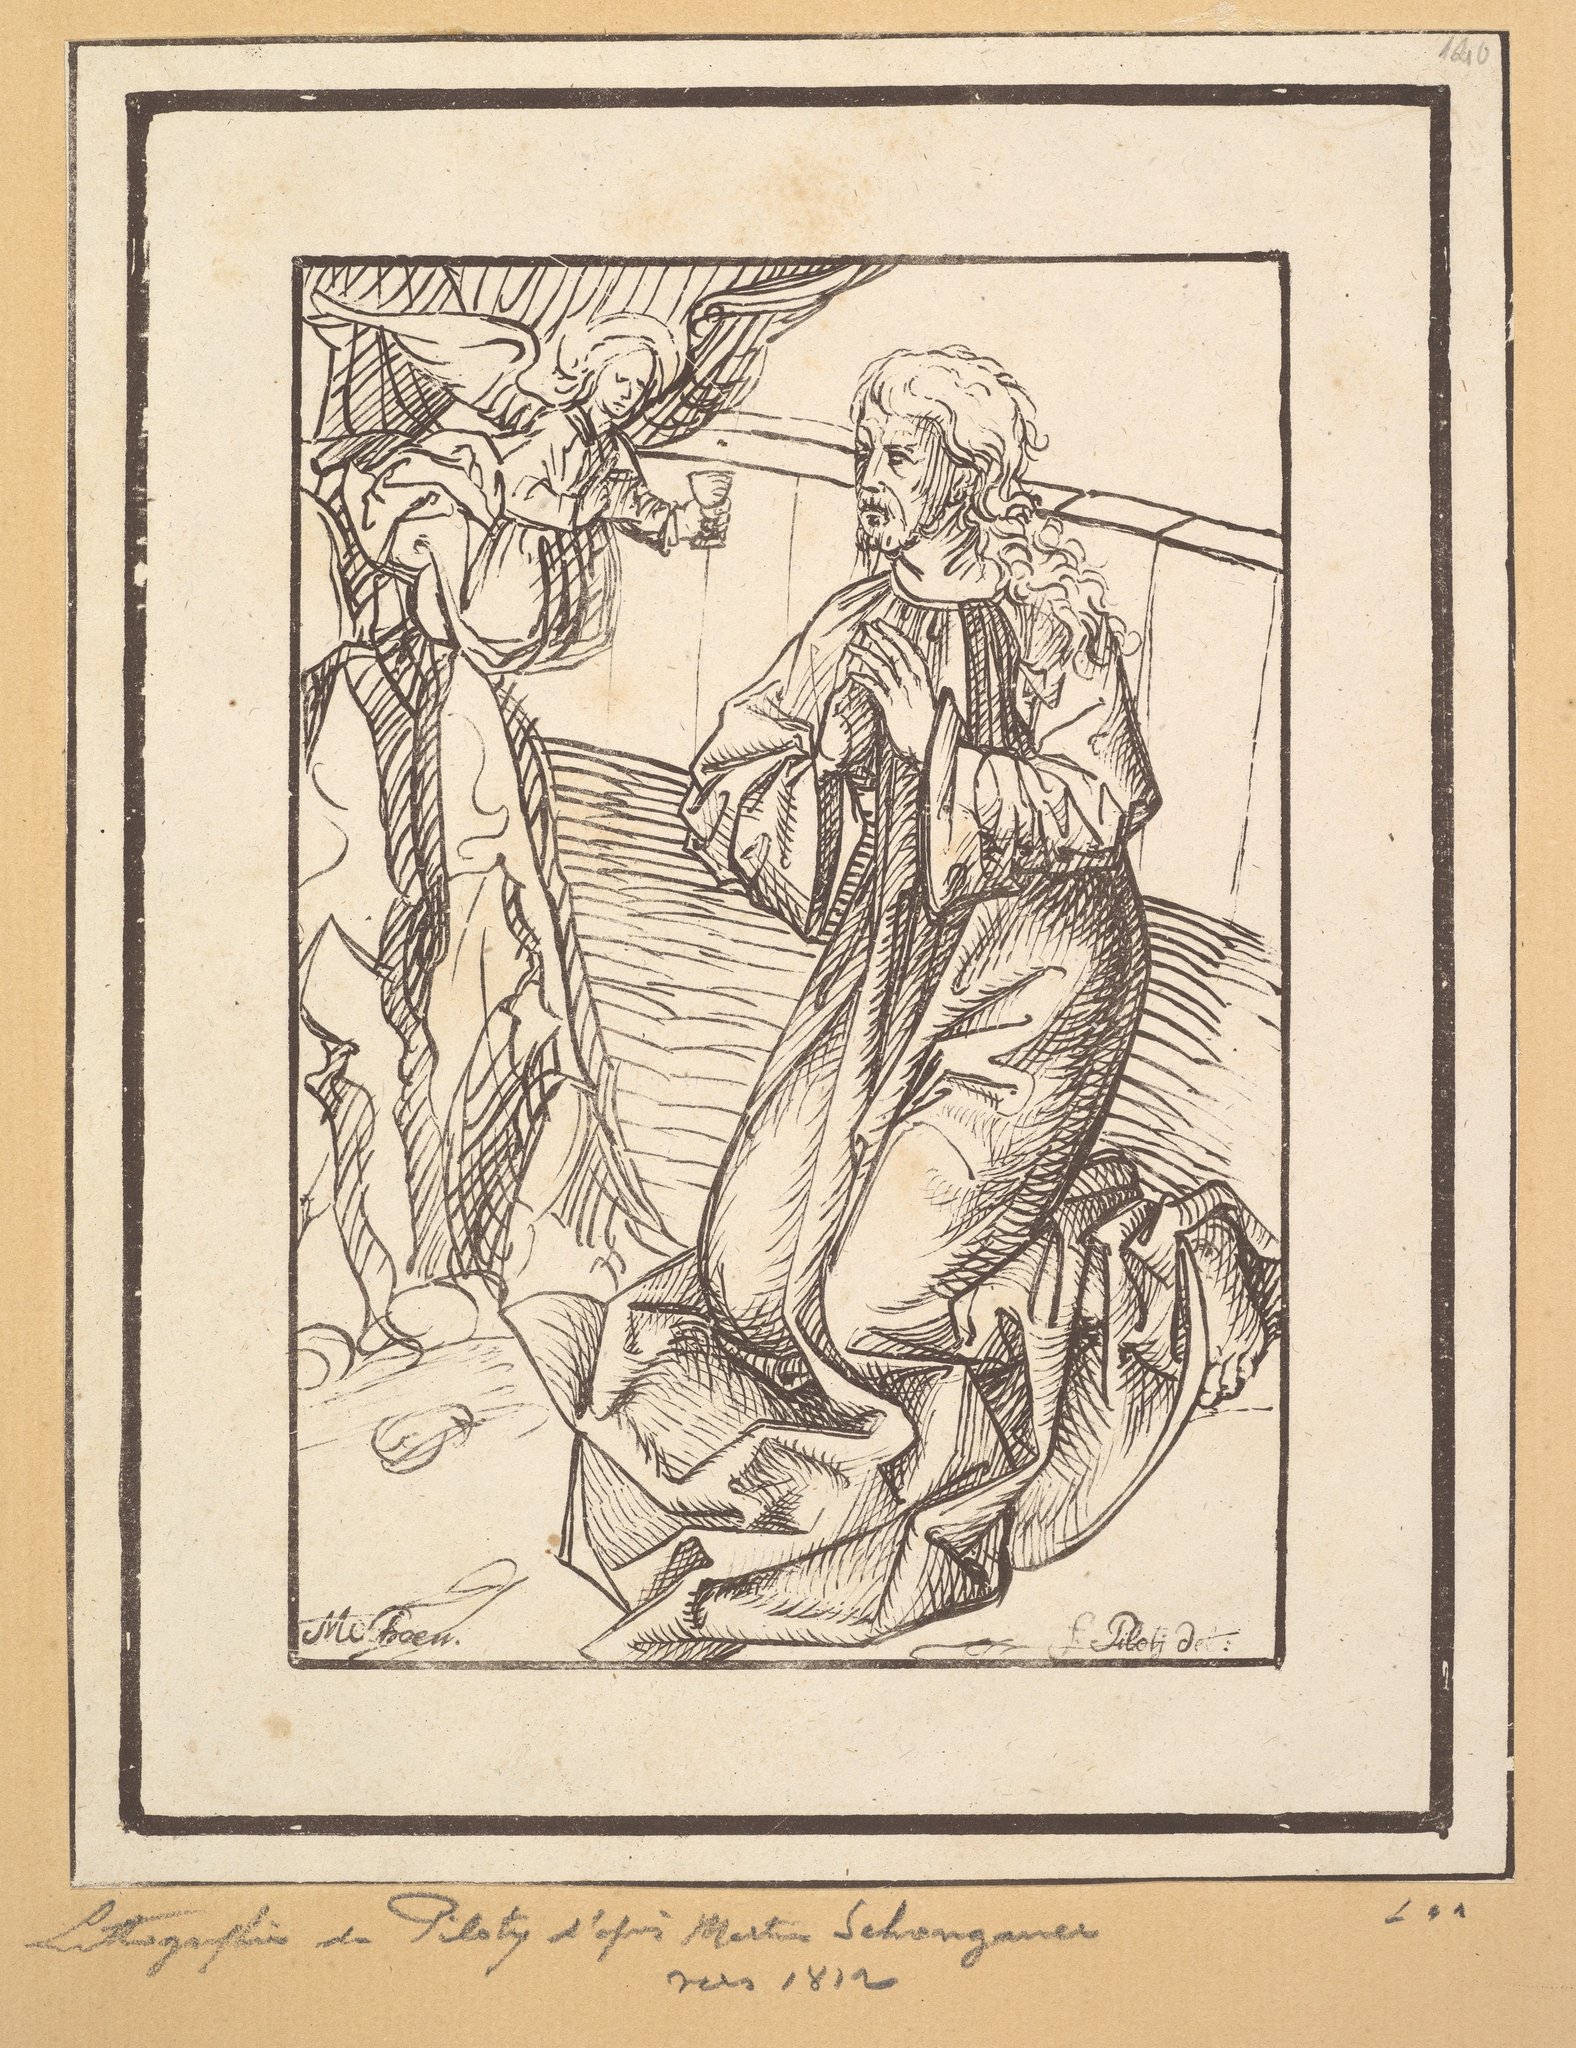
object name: print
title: Christ in Gethsemene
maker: ferdinand piloty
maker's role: artist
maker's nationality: german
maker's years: 1786-1844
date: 1801-1833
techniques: lithograph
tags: angels,christ